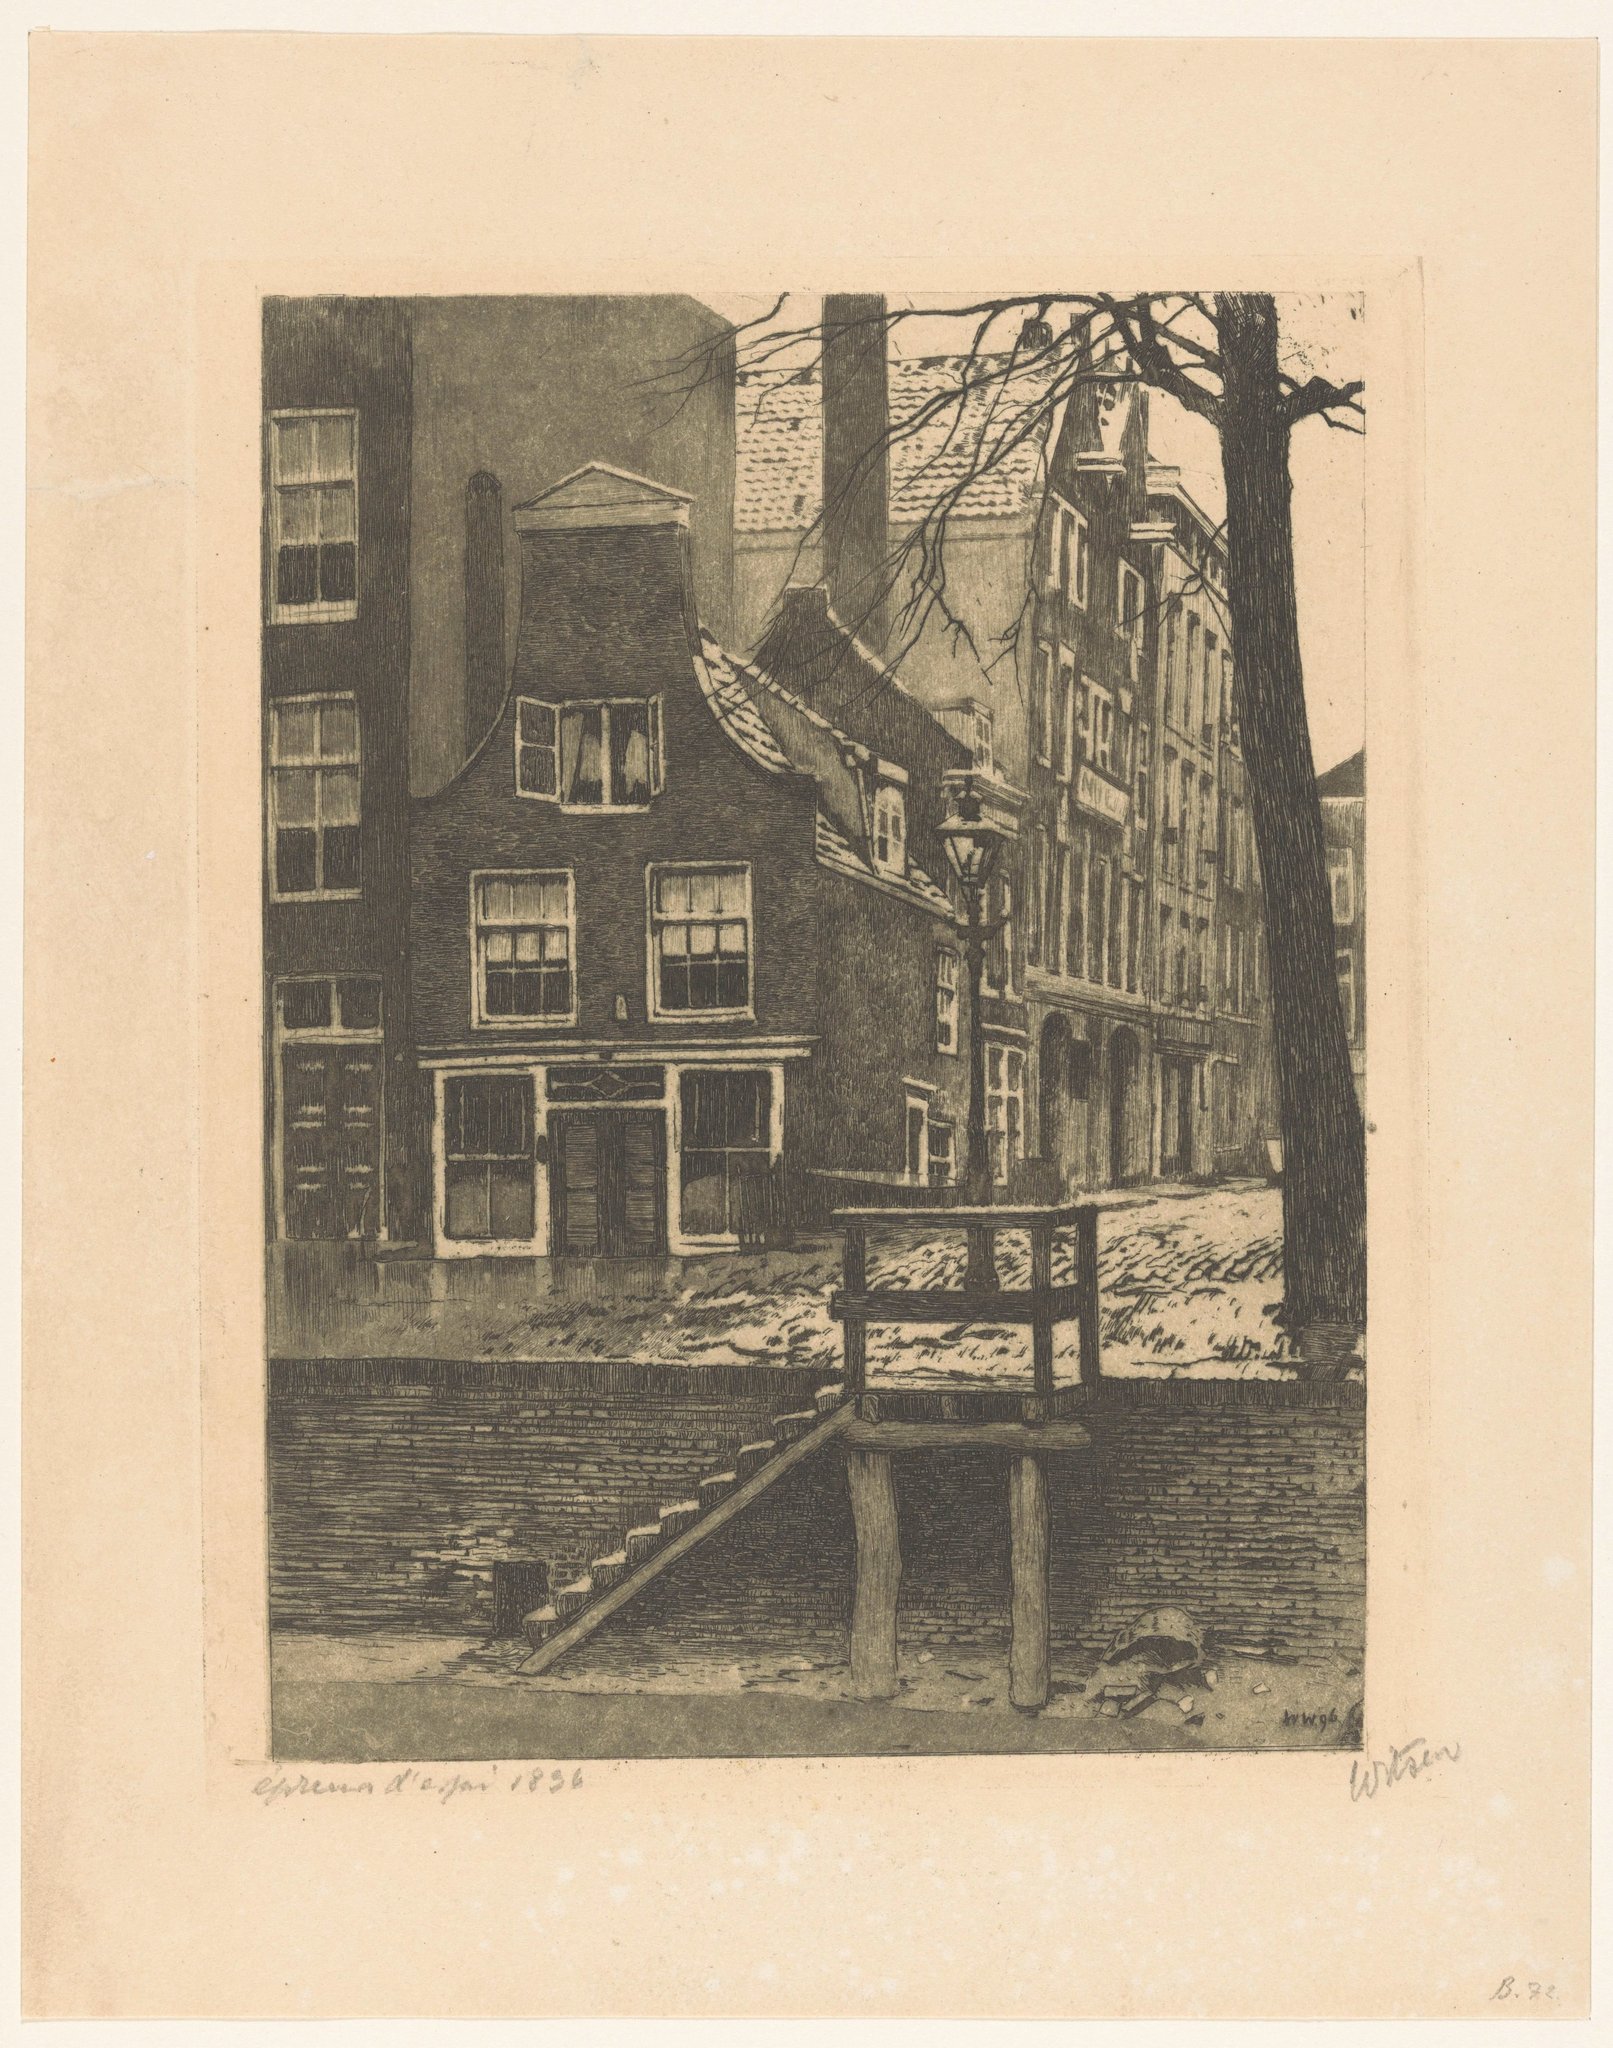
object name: print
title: Gezicht op de Bierhaven en de Oranjestraat in Rotterdam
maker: willem witsen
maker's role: draughtsman, painter, print maker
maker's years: 1860-1923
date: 1896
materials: paper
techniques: aquatint, etching, intaglio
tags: urban housing, canals, waters (in city)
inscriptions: inscription: ‘épreuve d'essai 1896’, signature: ‘Witsen’